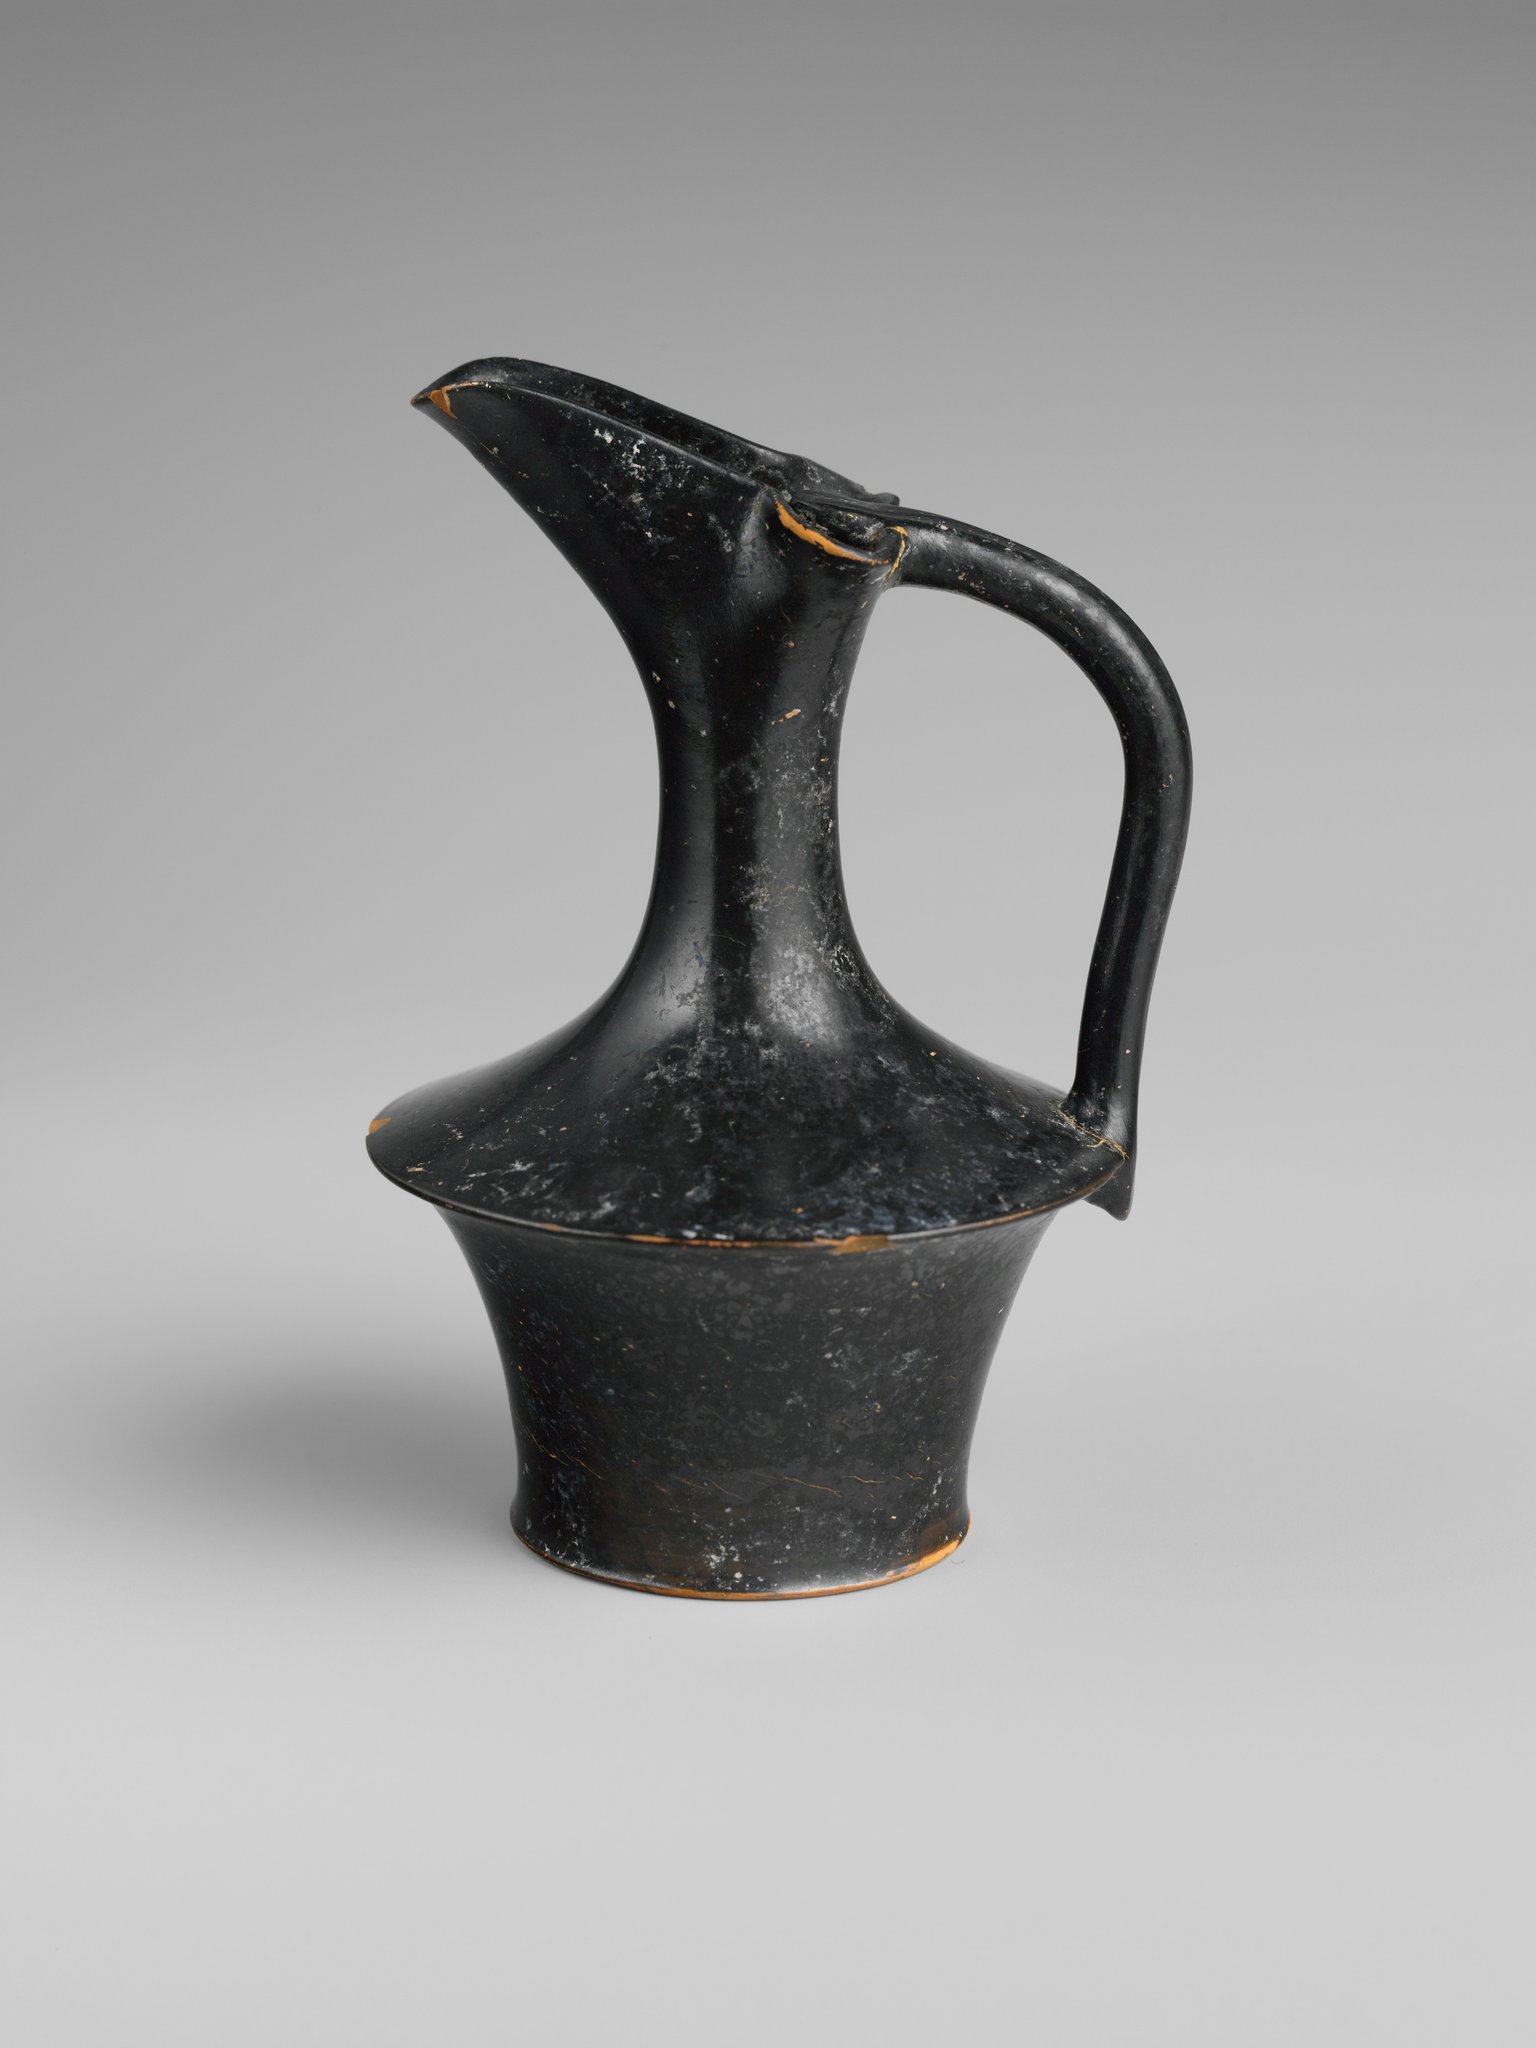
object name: oinochoe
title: Terracotta oinochoe (jug)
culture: greek, attic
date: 500-401 BCE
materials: terracotta